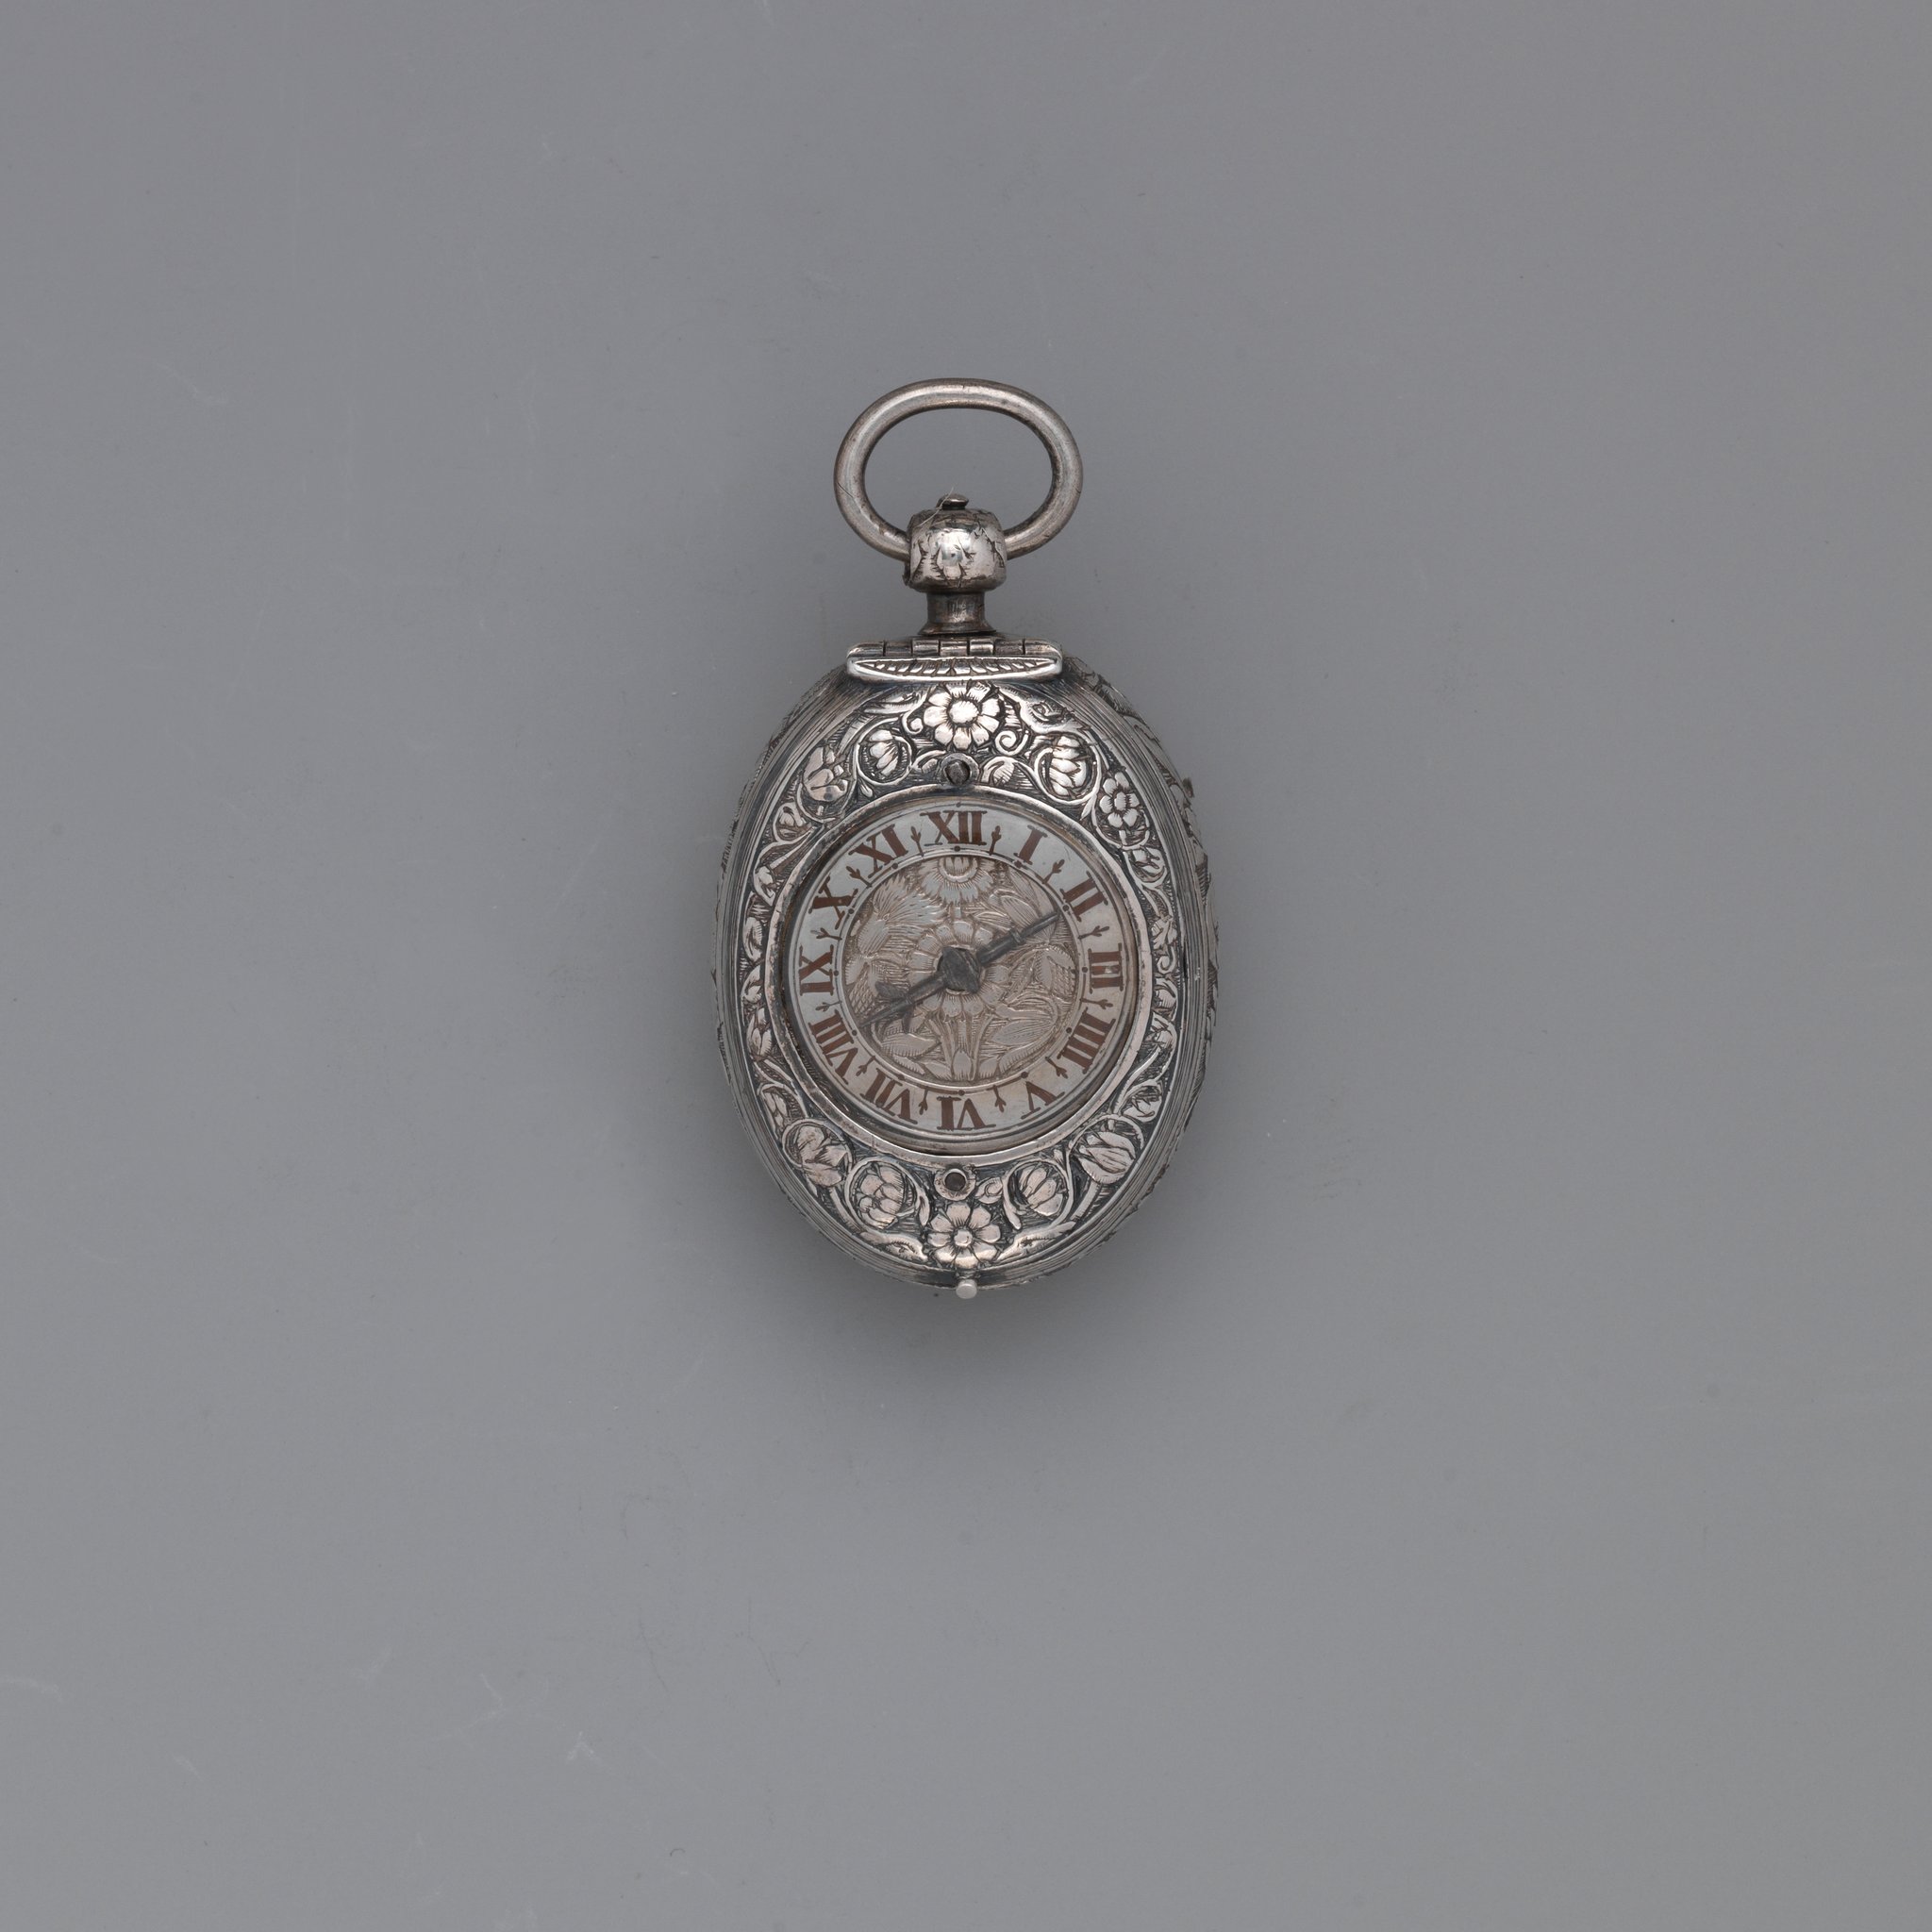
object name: watch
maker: john midnall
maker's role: maker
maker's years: 1620-1641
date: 1620-1630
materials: gilt brass, silver, steel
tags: flowers